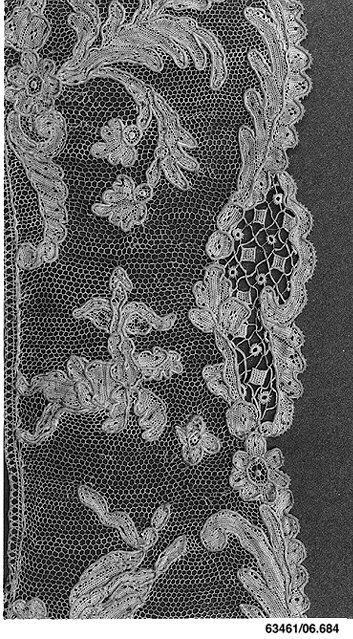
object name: fragment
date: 1750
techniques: lace